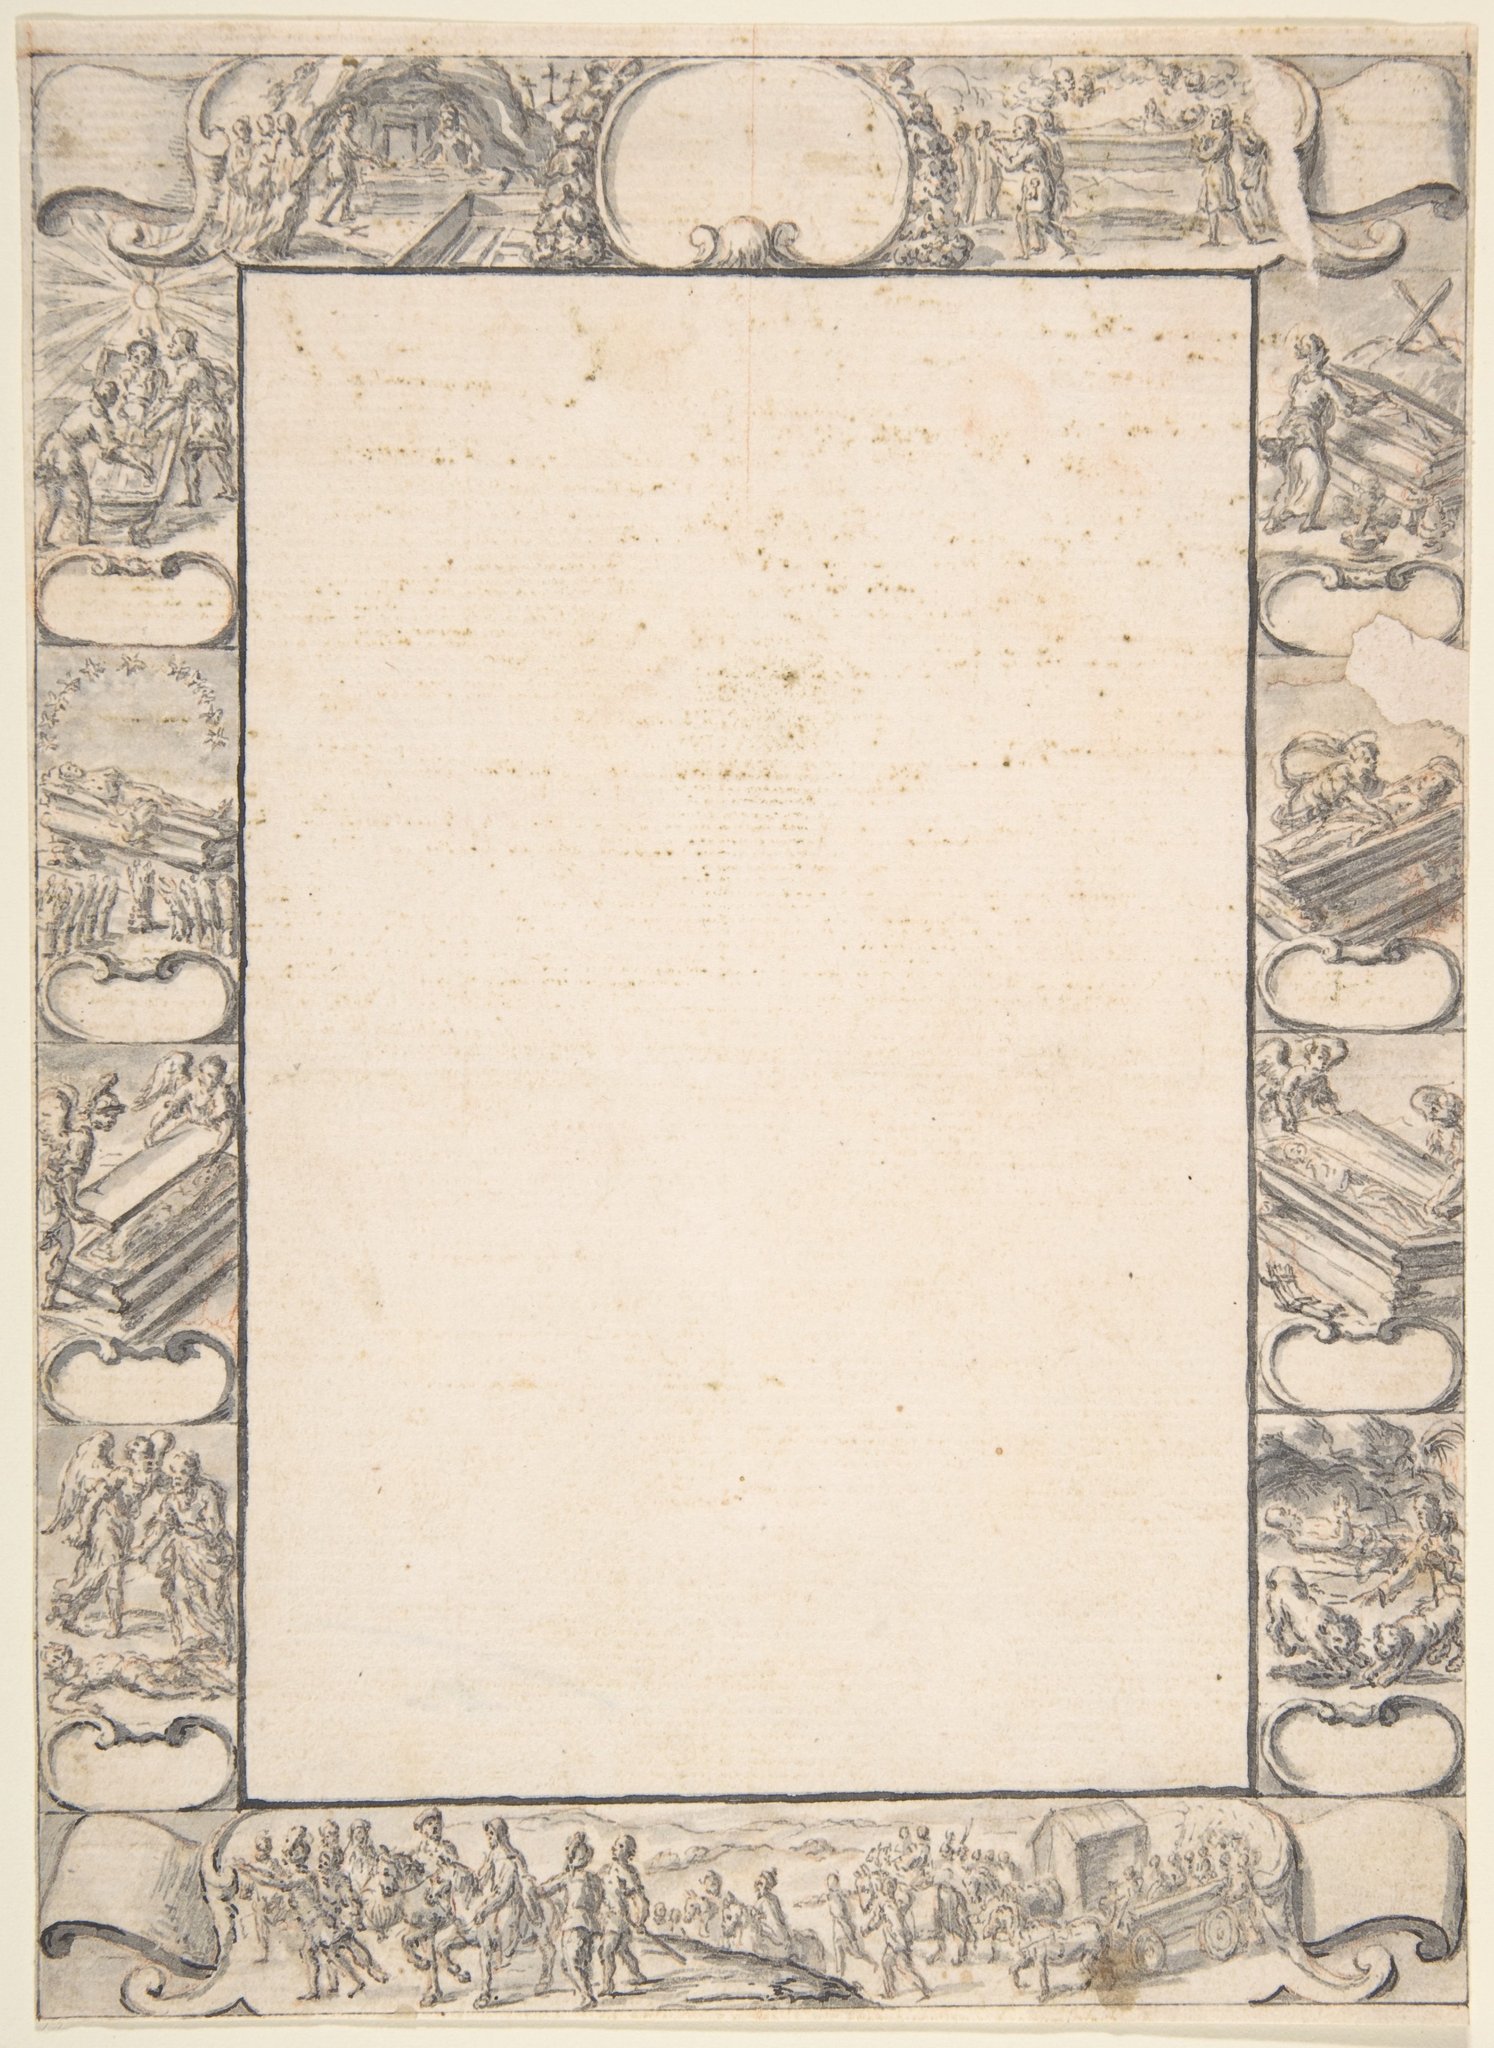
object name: drawing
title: Design for Border with Religious Scenes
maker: anonymous, italian, 17th century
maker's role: artist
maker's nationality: italian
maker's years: 1600-1700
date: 1601-1700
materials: ink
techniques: brush, pen, wash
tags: corpses,horses,angels,crowd,carriages